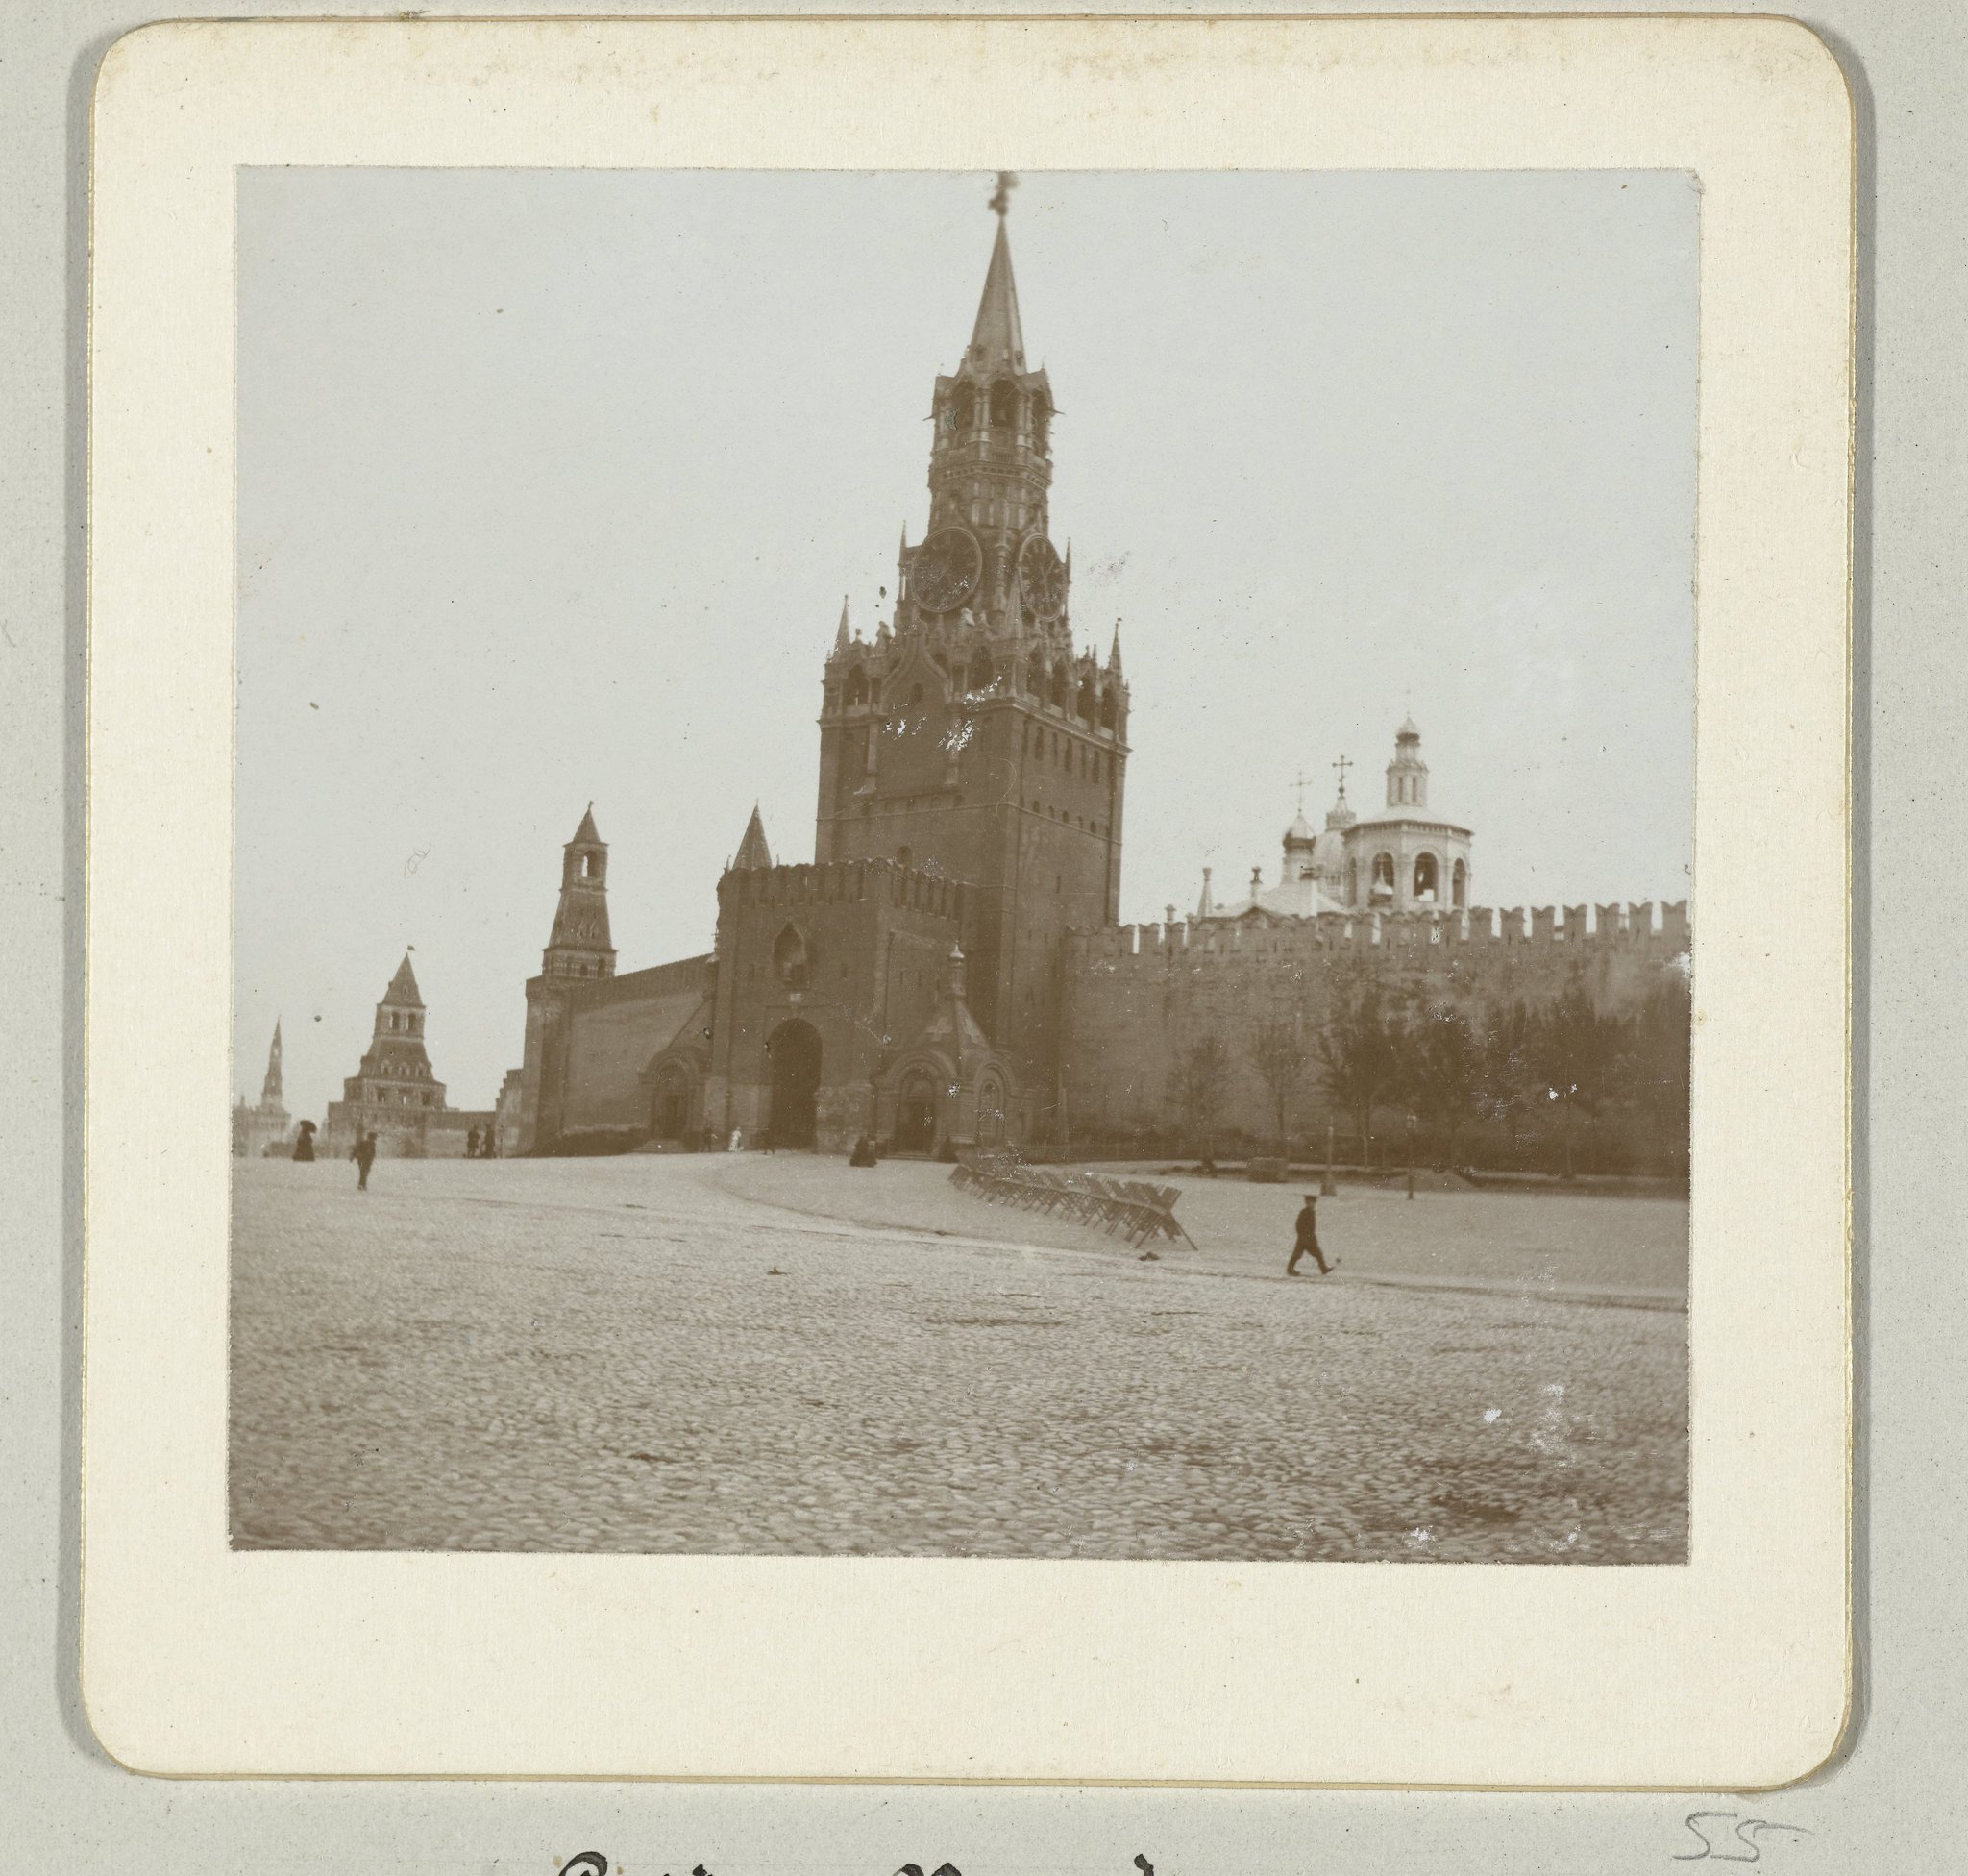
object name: photograph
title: Spasskaya toren met toegang tot het Kremlin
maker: henry pauw van wieldrecht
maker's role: fotograaf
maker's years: 1863-1912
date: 1898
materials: paper, photographic support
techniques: albumen print, hand coloring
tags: moskou